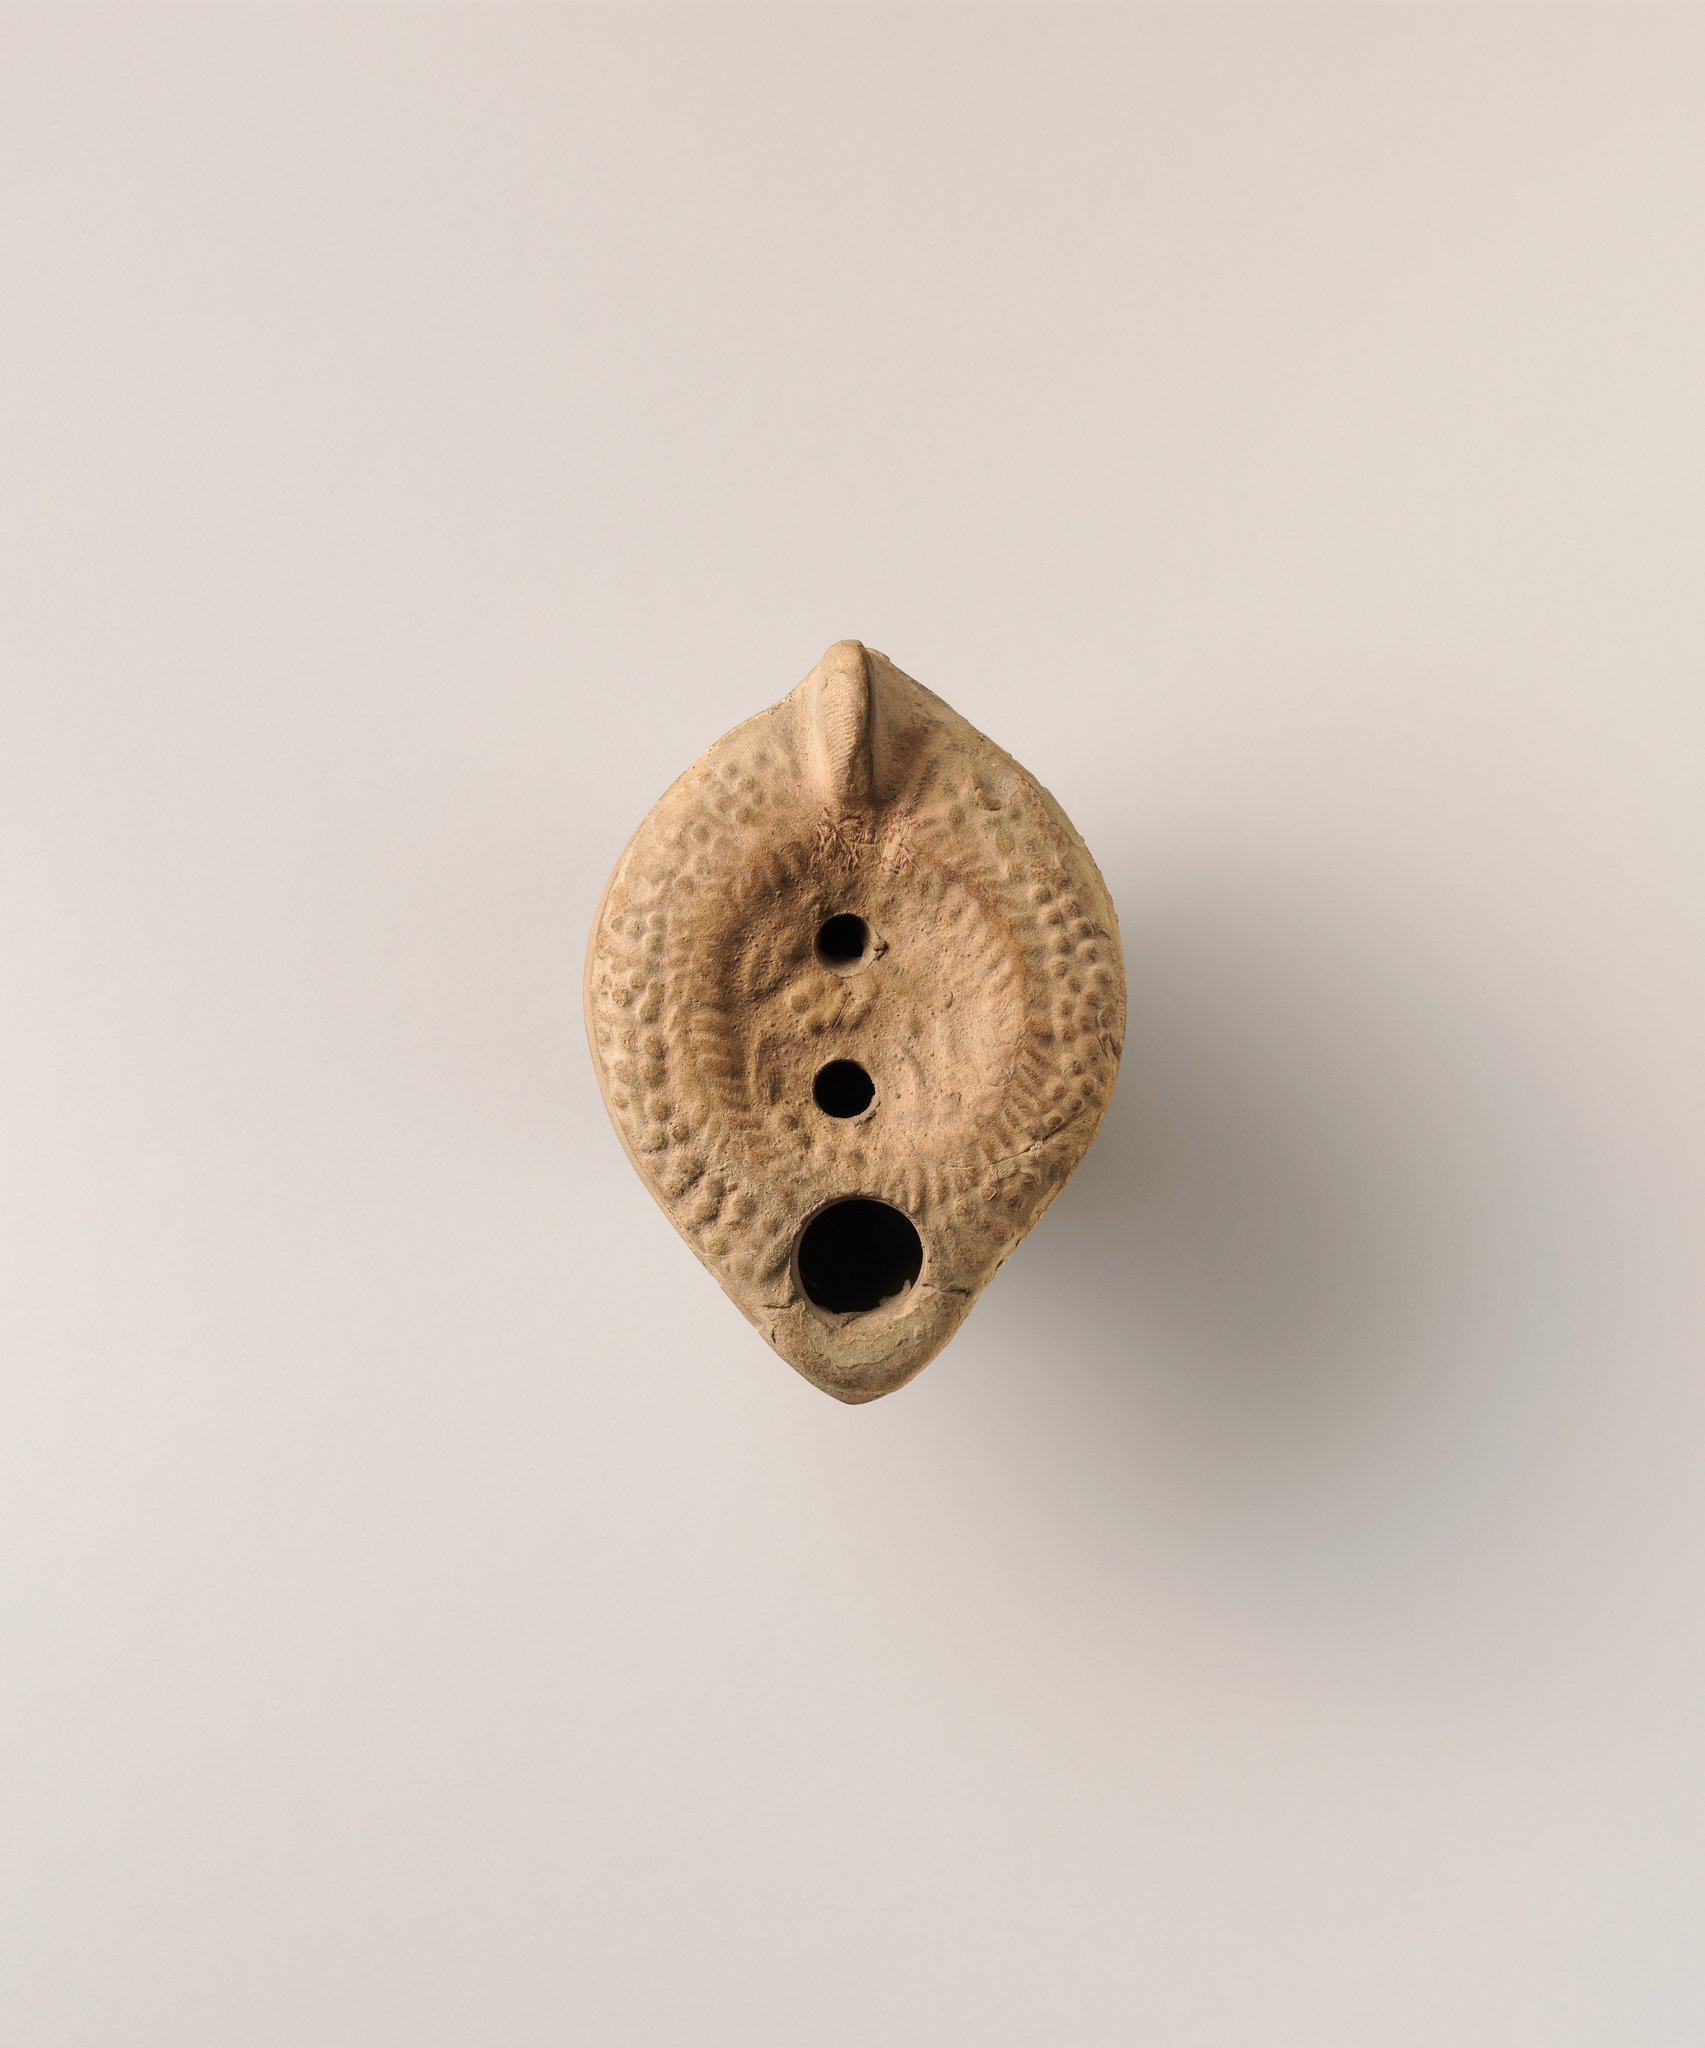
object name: lamp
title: Terracotta oil lamp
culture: roman, cypriot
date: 301-500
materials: terracotta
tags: horses